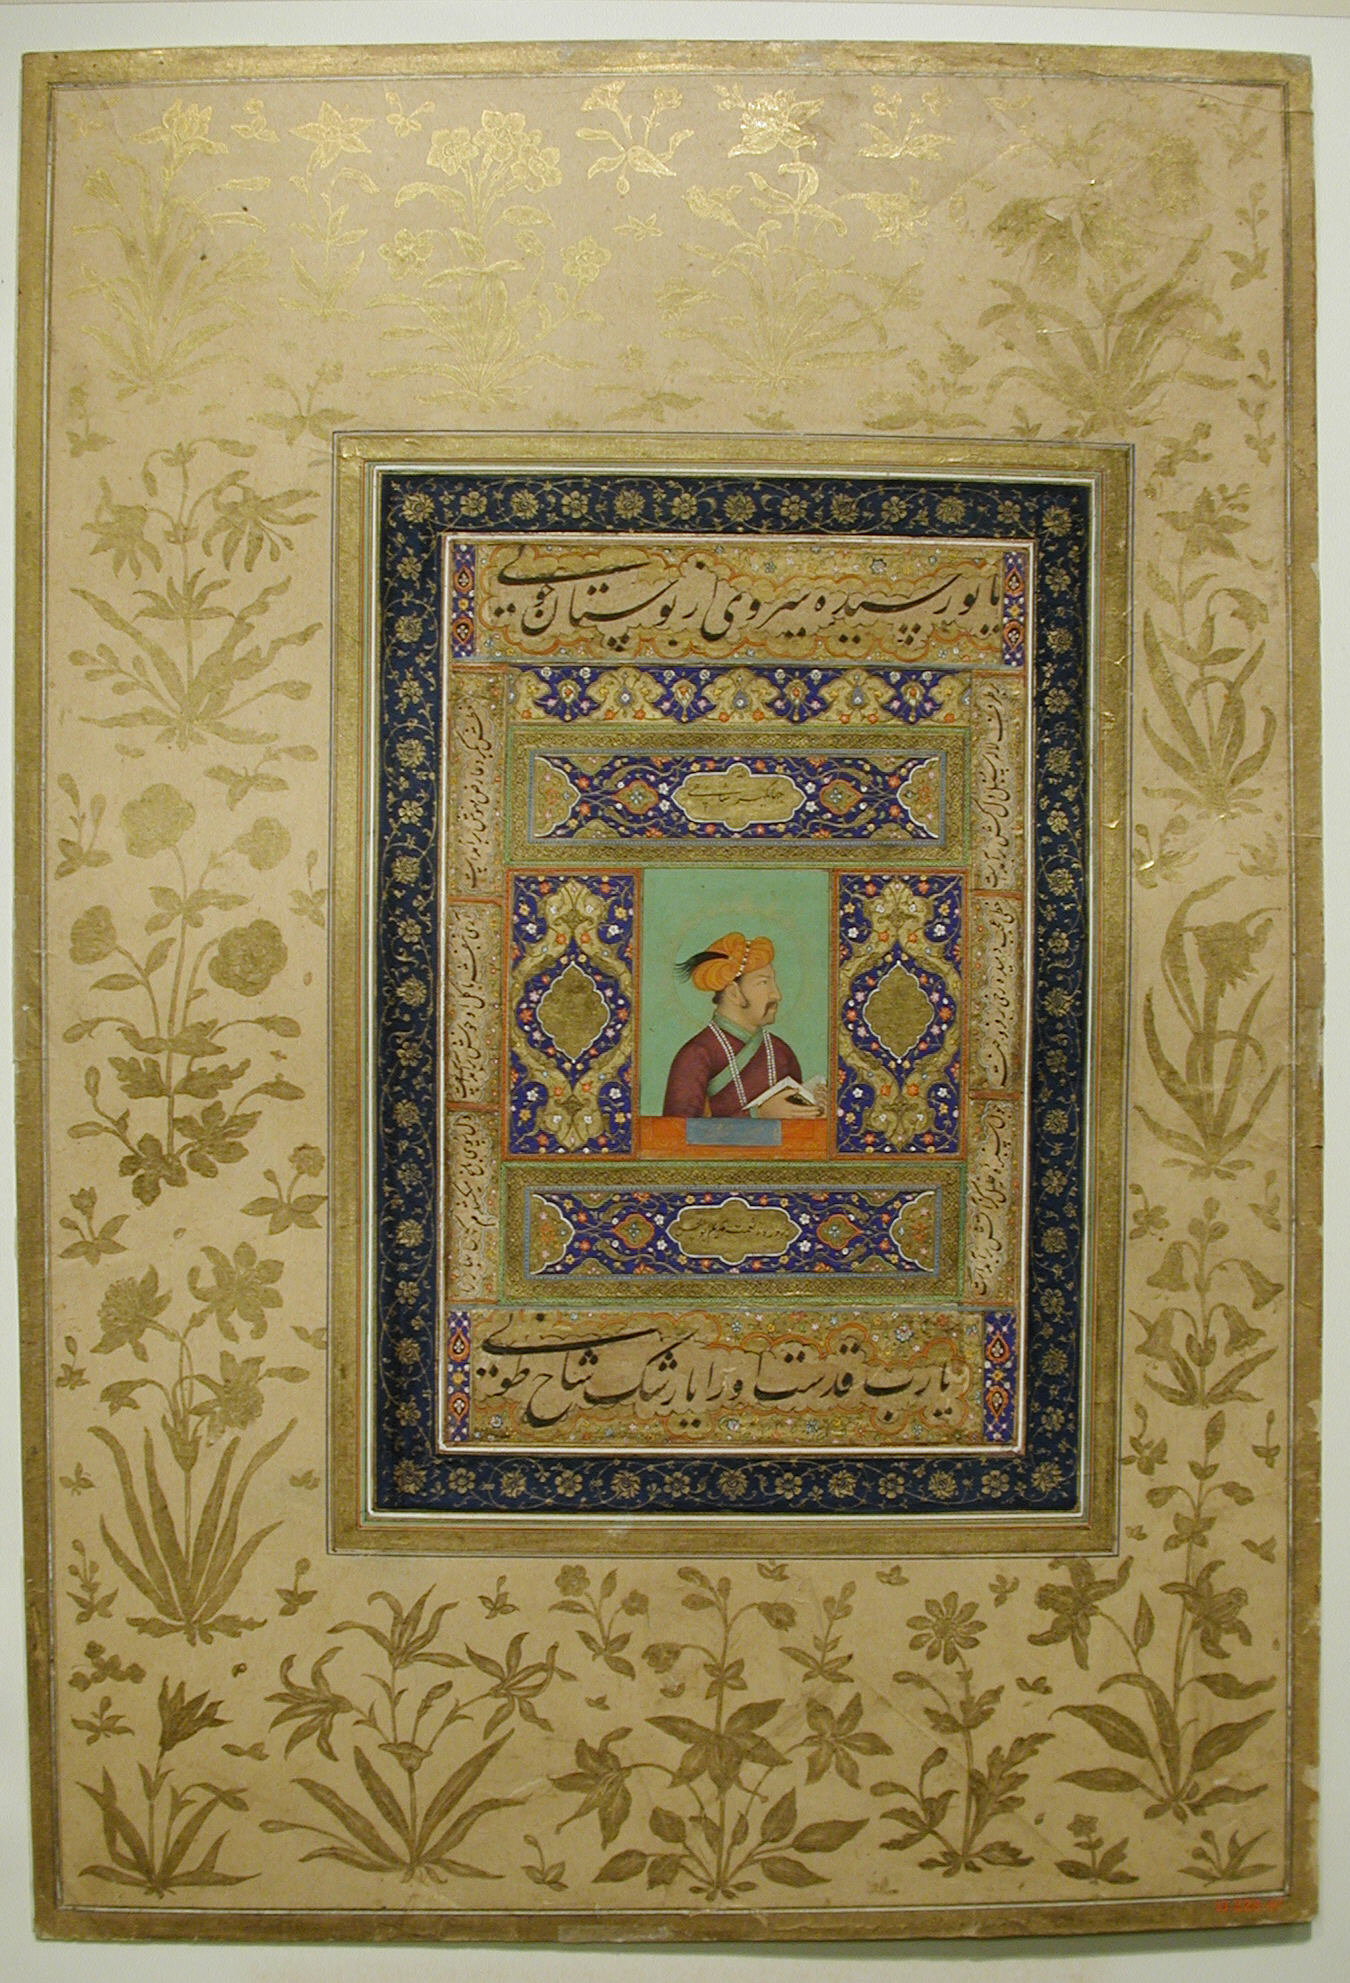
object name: illustrated single work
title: Portrait of Emperor Jahangir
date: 1615-1620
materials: gold, ink, paper, watercolor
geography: india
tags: men,profiles